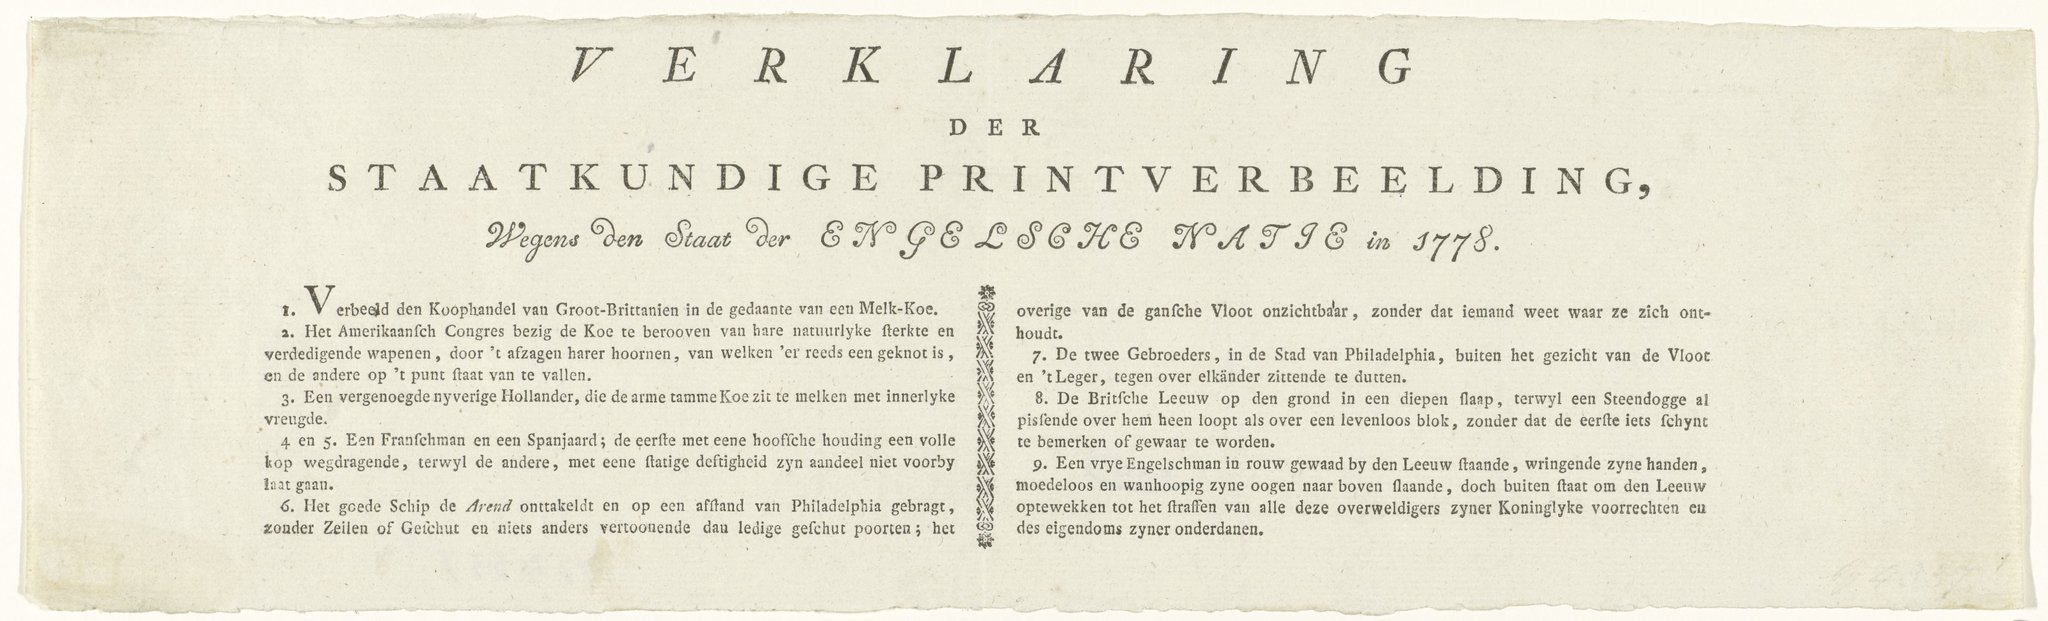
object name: text sheet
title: Verklaring der Staatkundige Printverbeelding, Wegens den Staat der Engelsche Natie in 1778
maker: Anonymous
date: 1778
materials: paper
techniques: letterpress printing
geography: northern netherlands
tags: philadelphia, amerikaanse vrijheidsoorlog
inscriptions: collector's mark: Lugt 2228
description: Tekstblad met een verklaring van de voorstelling van de eerste spotprent op de Engelse verliezen in de strijd met Amerika in 1778. Tekst in twee kolommen met een uitleg van de nummers 1-9.